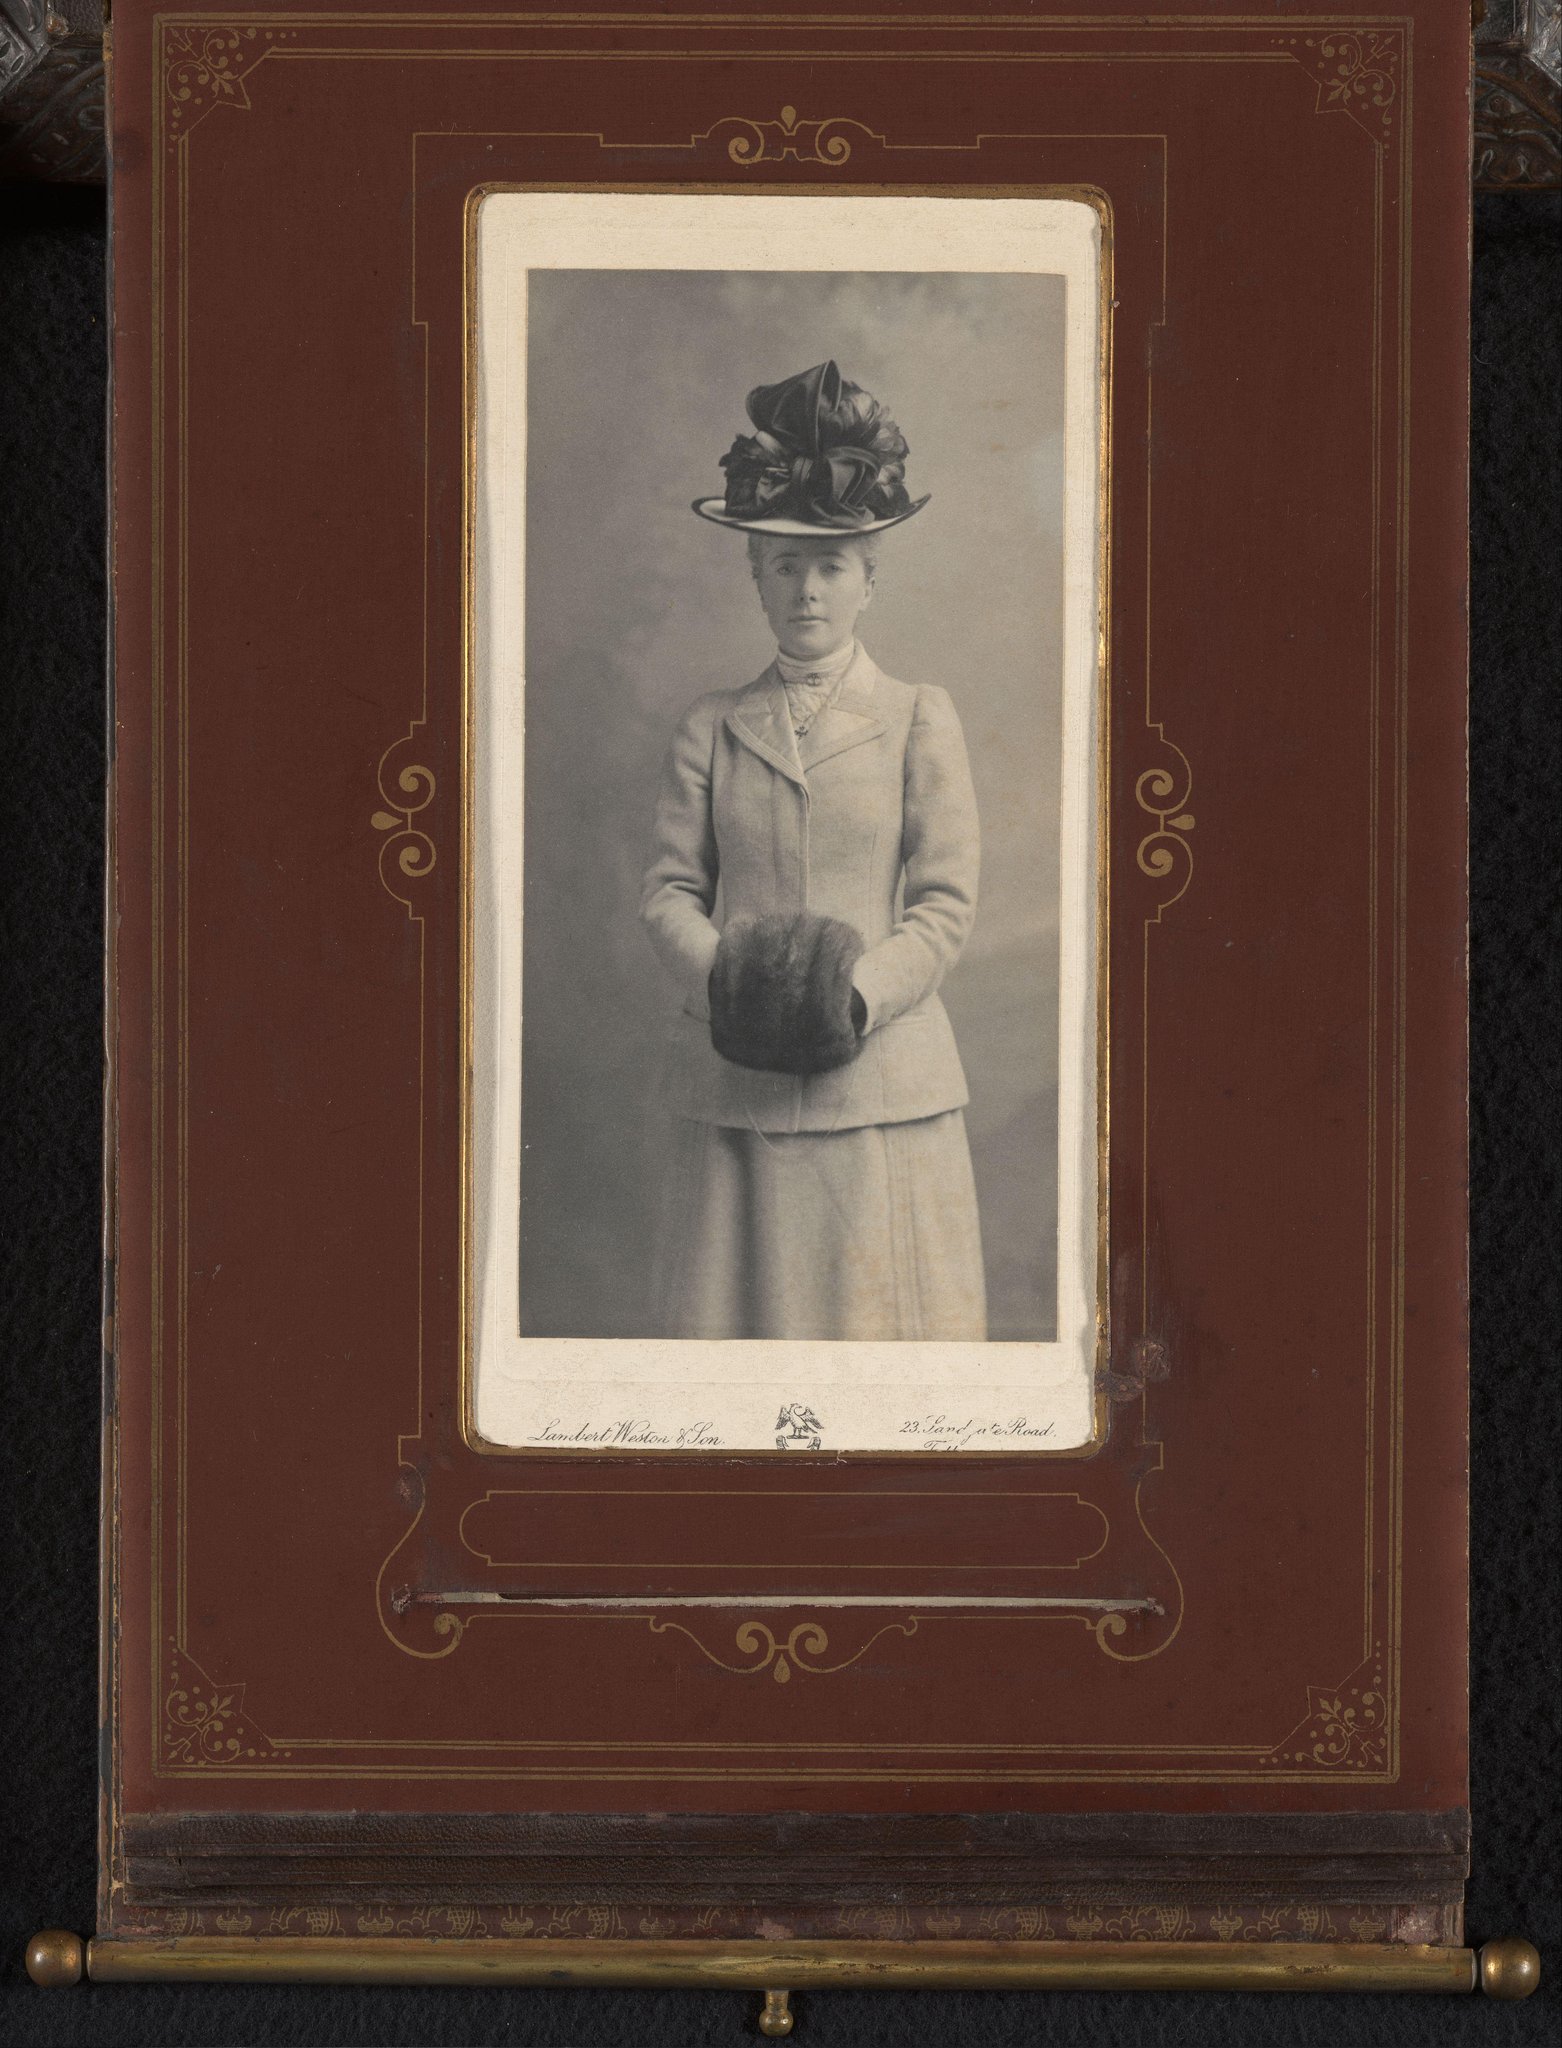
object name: cabinet photograph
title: Portret van een staande vrouw met hoed en mof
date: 1883-1914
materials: cardboard, photographic support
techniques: platinum process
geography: folkestone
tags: historical persons - bb - woman, muff, head-gear: hat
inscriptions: inscription: ‘Lambert Weston & Son/ 23, Sandgate Road/ Folkestone’